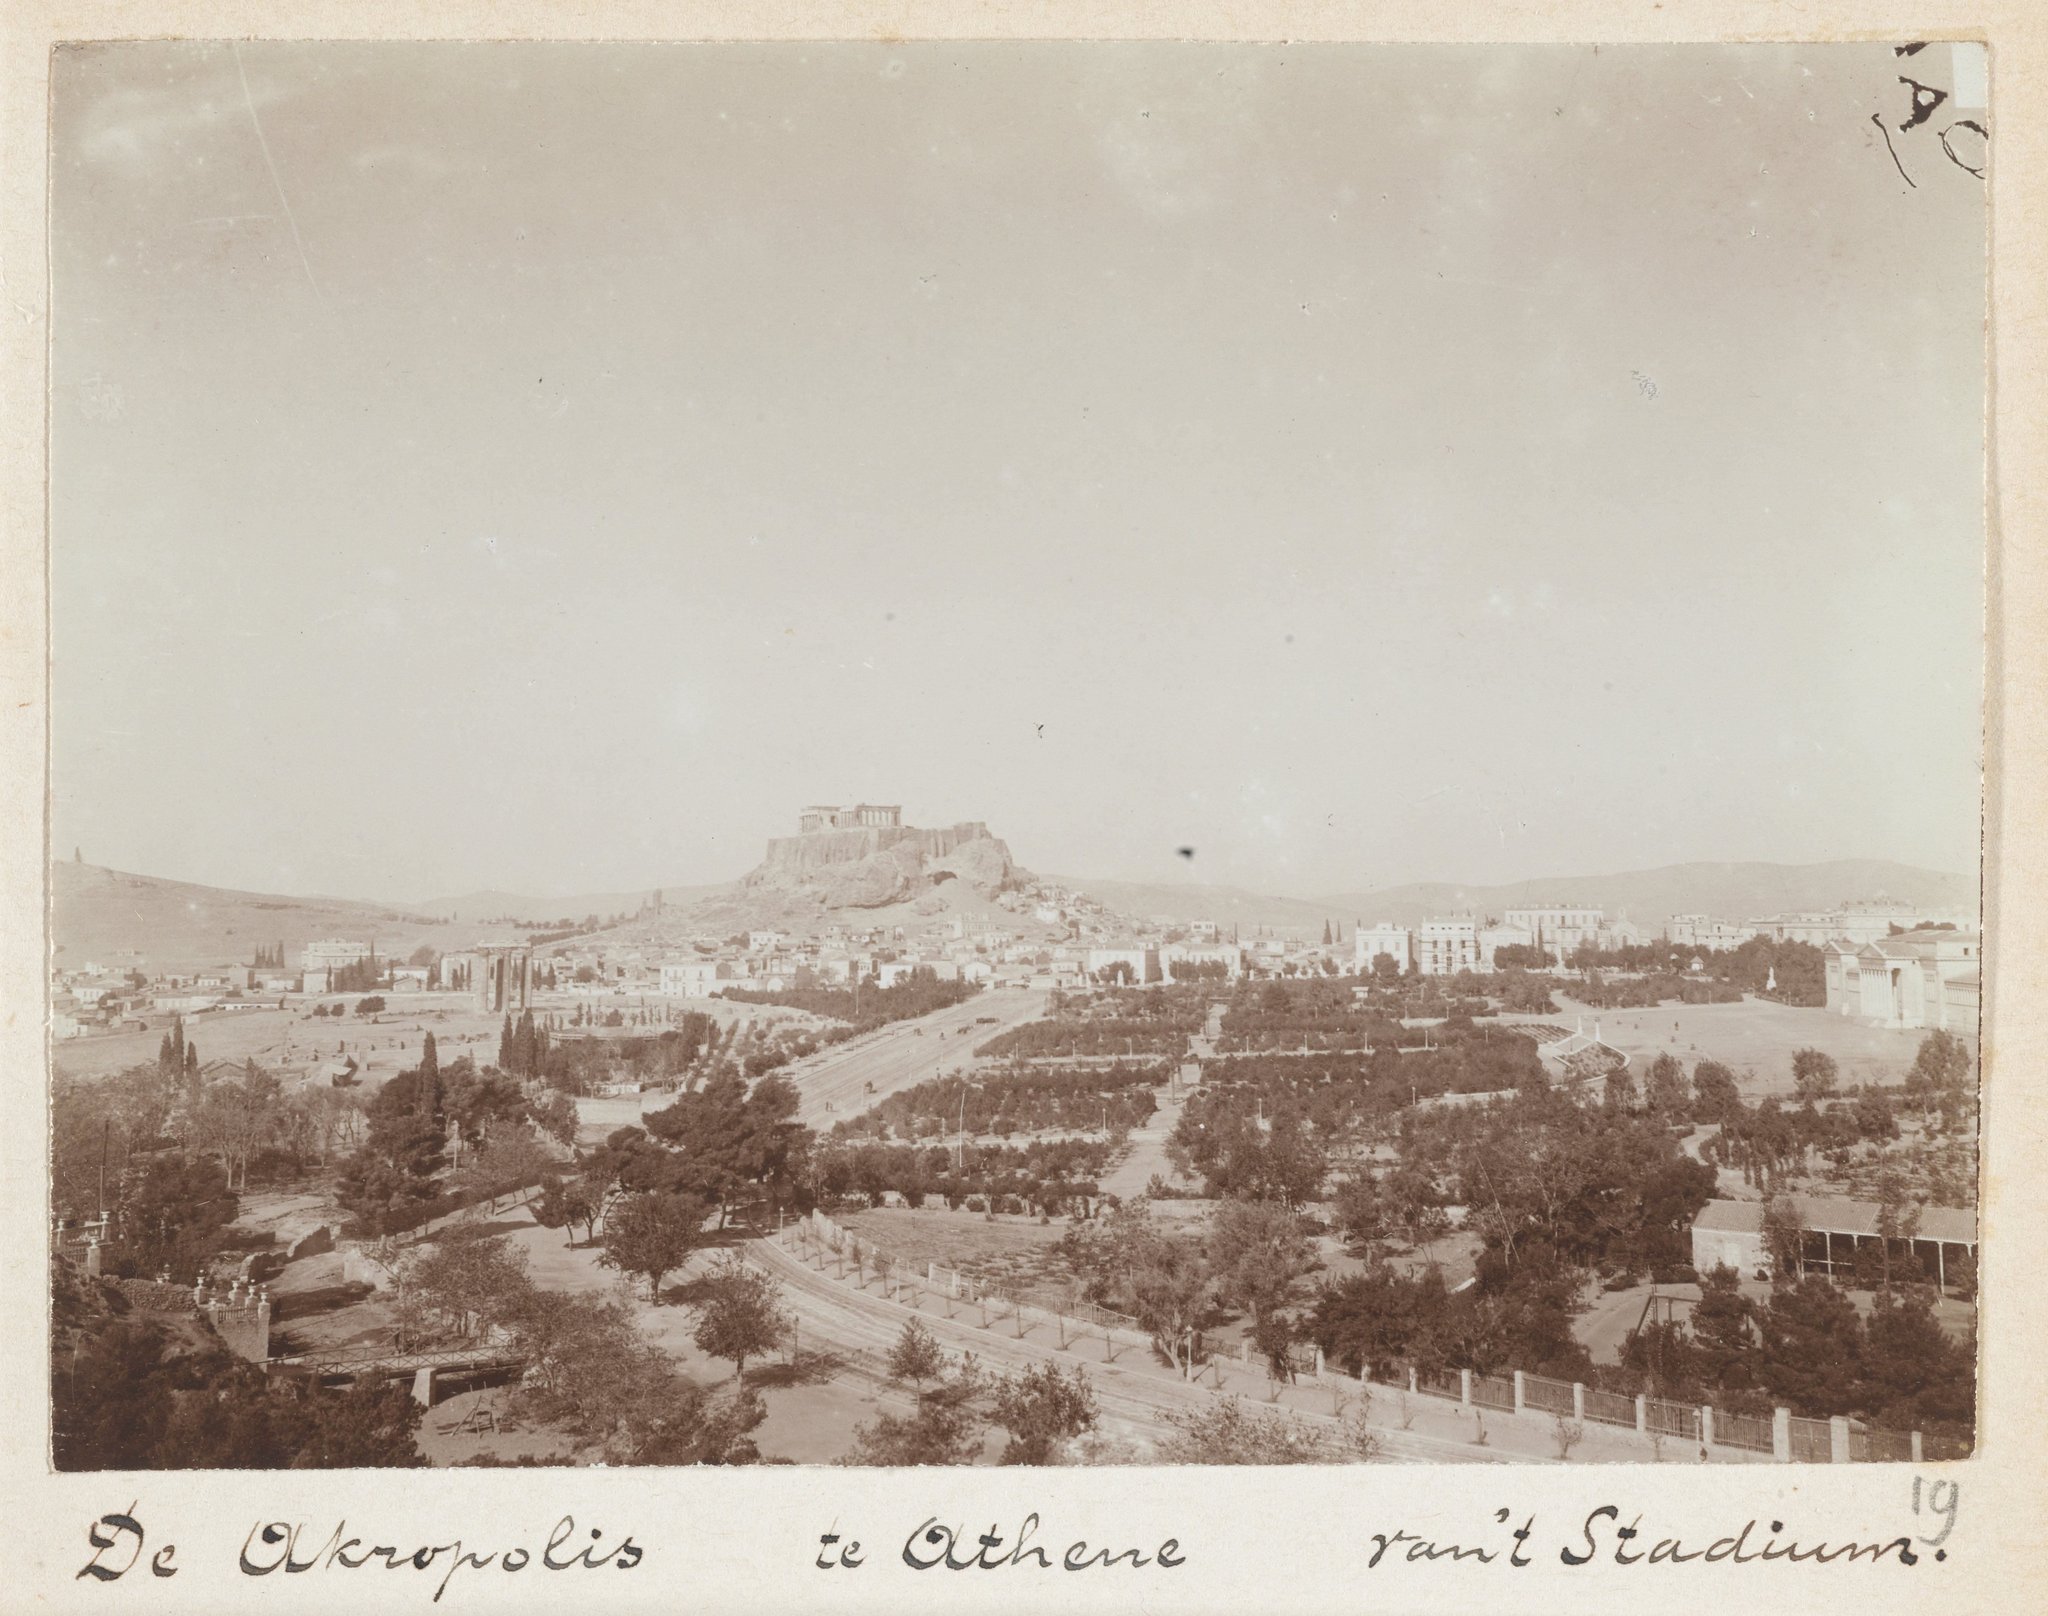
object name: photograph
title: Gezicht op de Akropolis van Athene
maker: johannes lodewijk heldring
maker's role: fotograaf, predikant, schrijver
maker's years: 1852-1923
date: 1898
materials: paper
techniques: collodion silver print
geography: athens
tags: fortress, city-view in general; 'veduta'